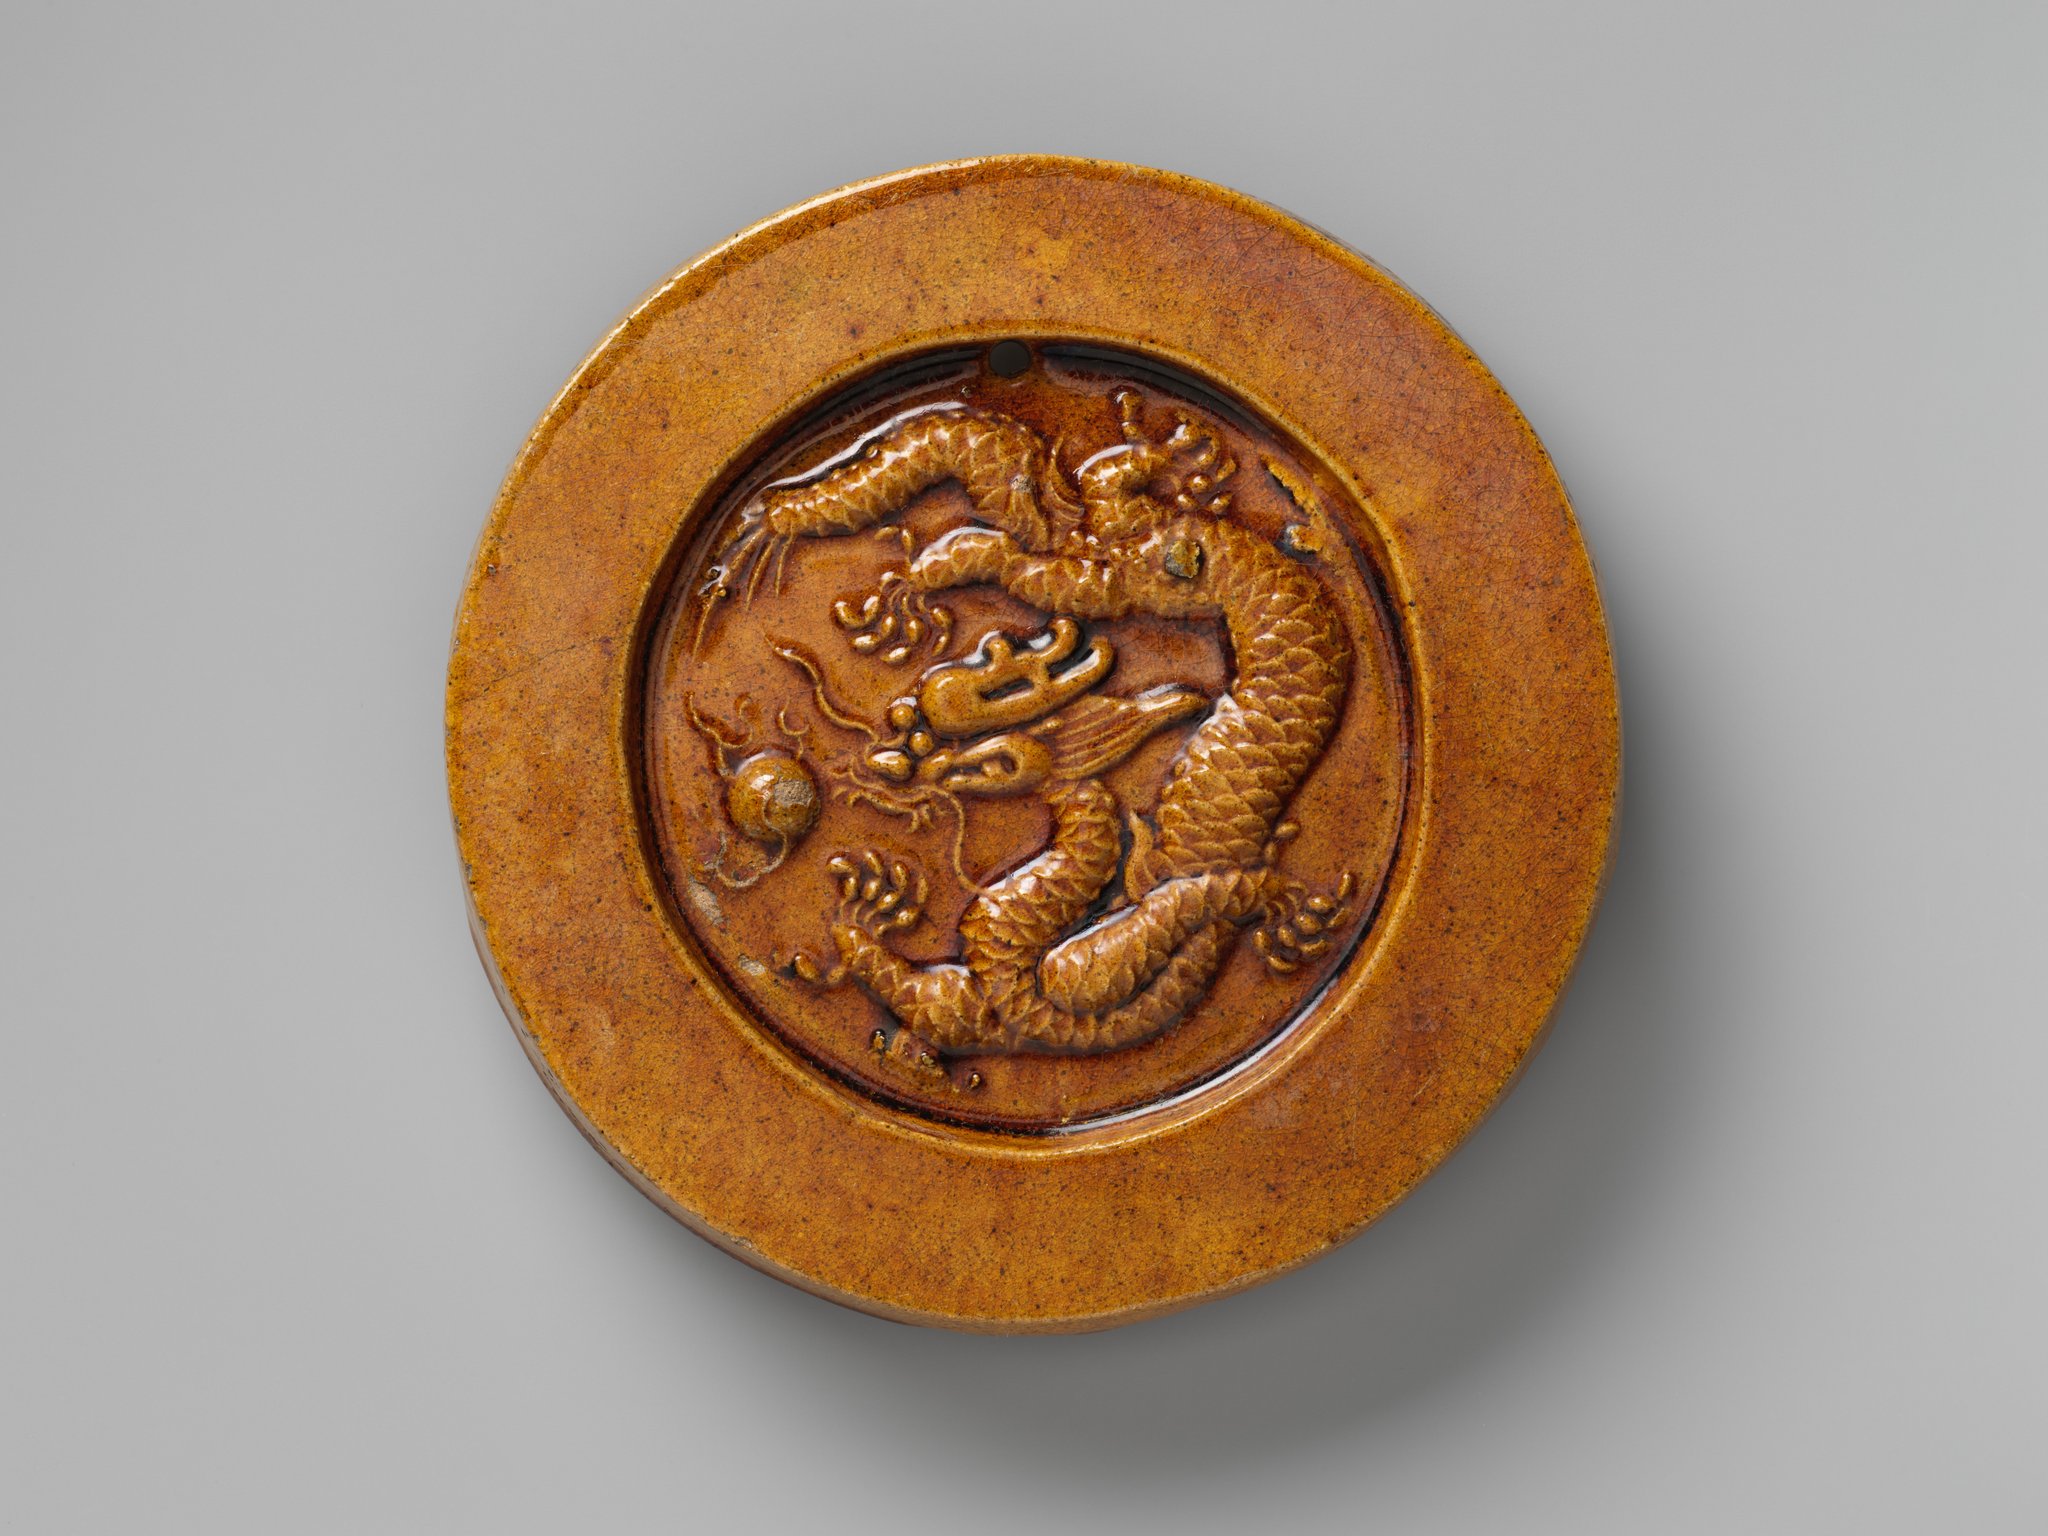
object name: roof tile end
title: Roof tile end with dragon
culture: chinese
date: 1701-1800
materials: earthenware, glaze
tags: dragons